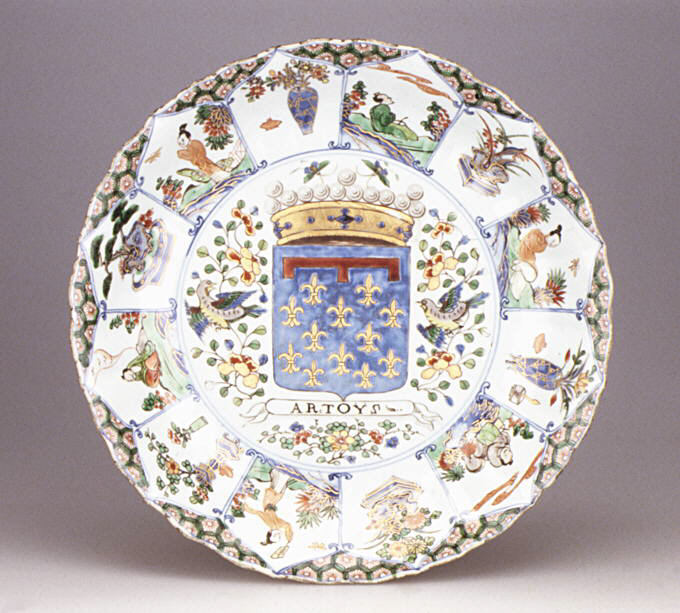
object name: plate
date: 1701-1725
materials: hard paste porcelain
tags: birds,men,flowers,coat of arms